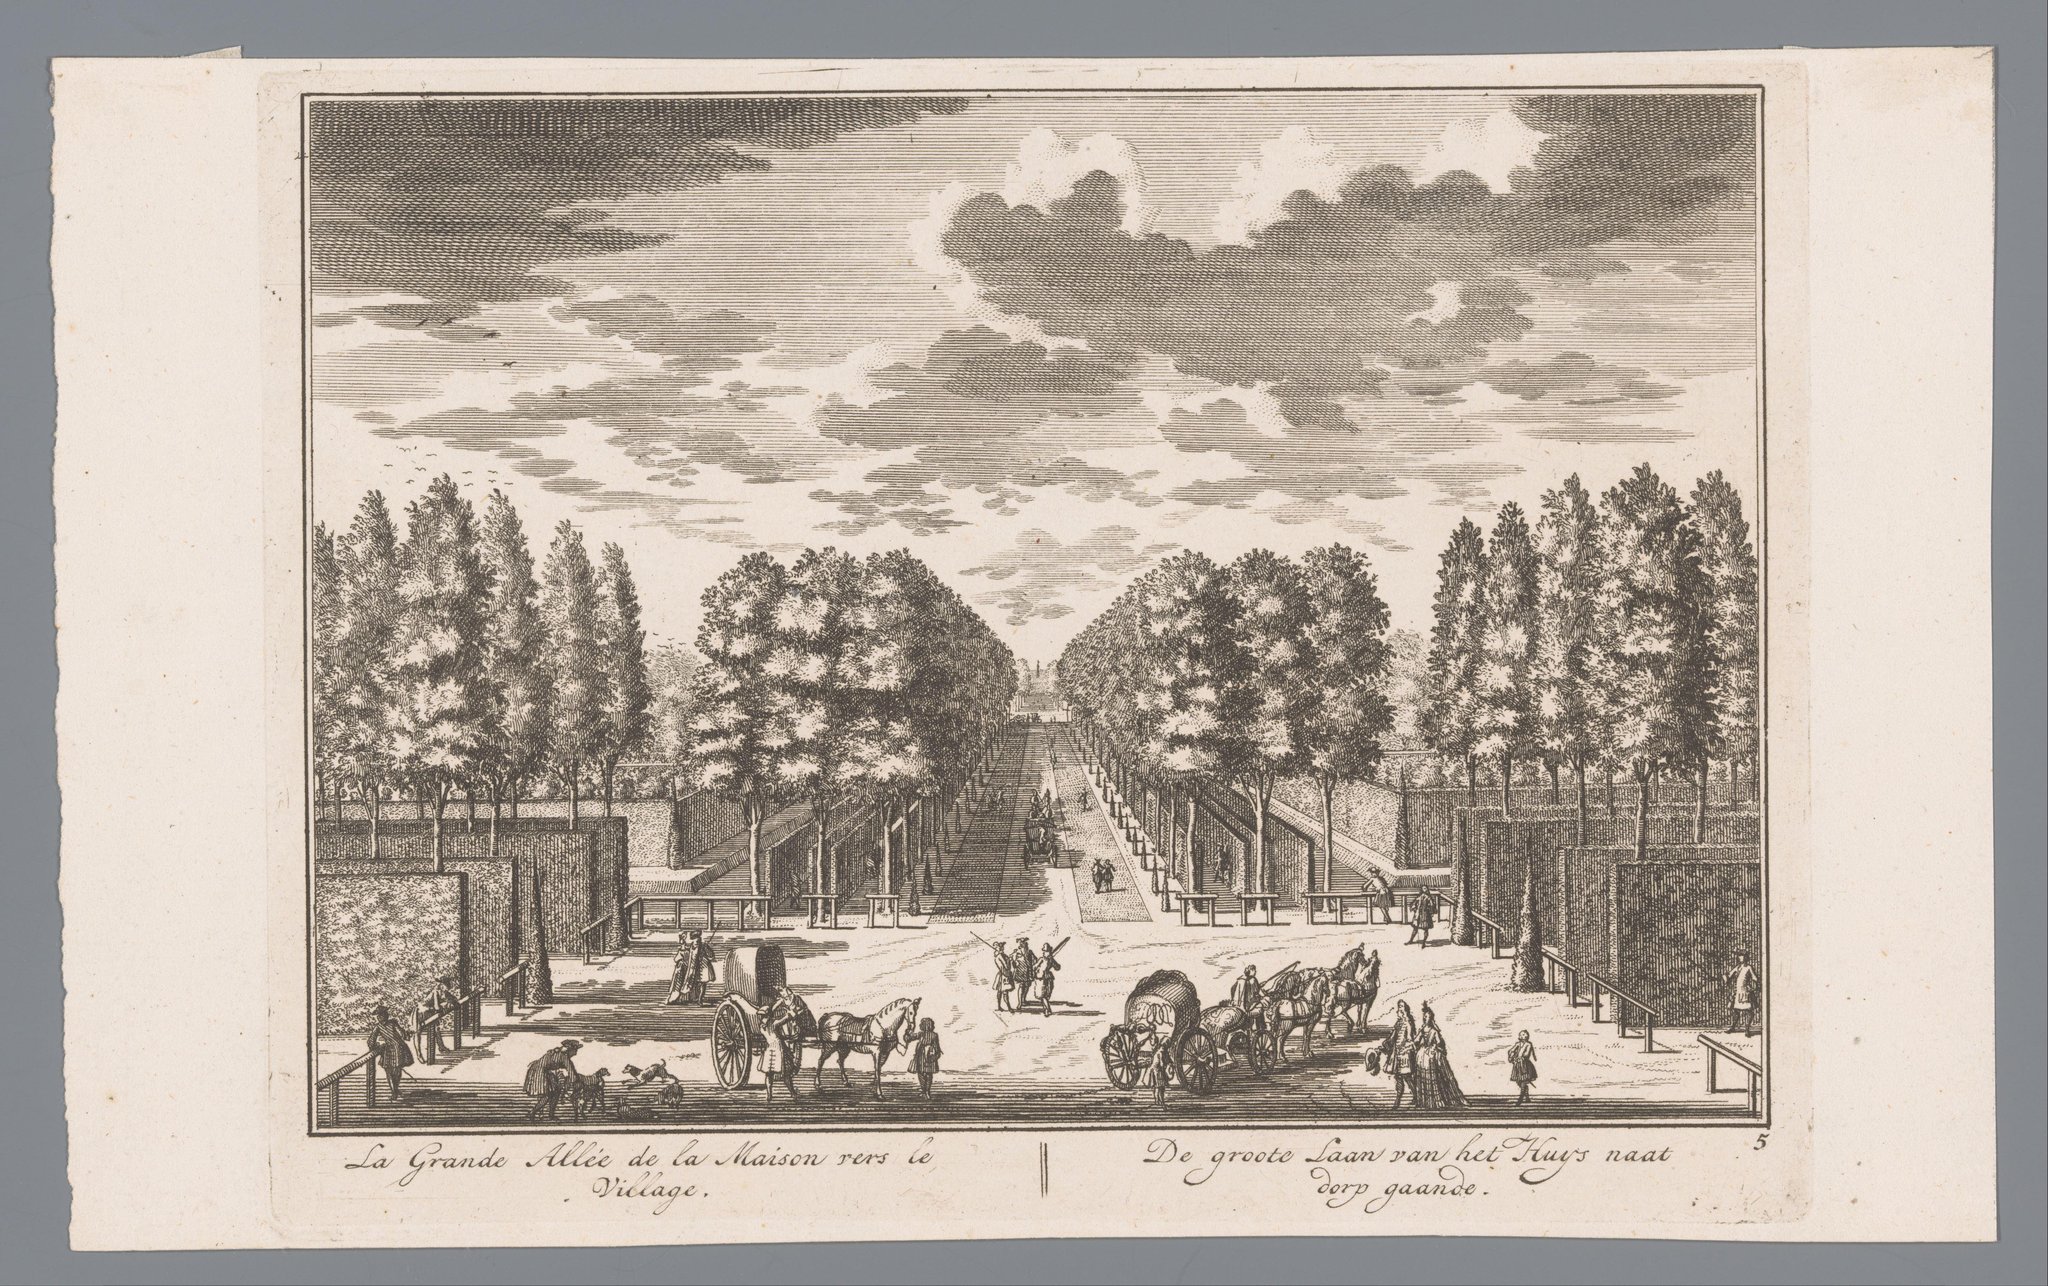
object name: print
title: La grande allée de la maison vers le village / De groote laan van het huys naat dorp gaande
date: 1682-1726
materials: paper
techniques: etching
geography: amsterdam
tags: castle, landscape with tower or castle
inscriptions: collector's mark: Lugt 2233